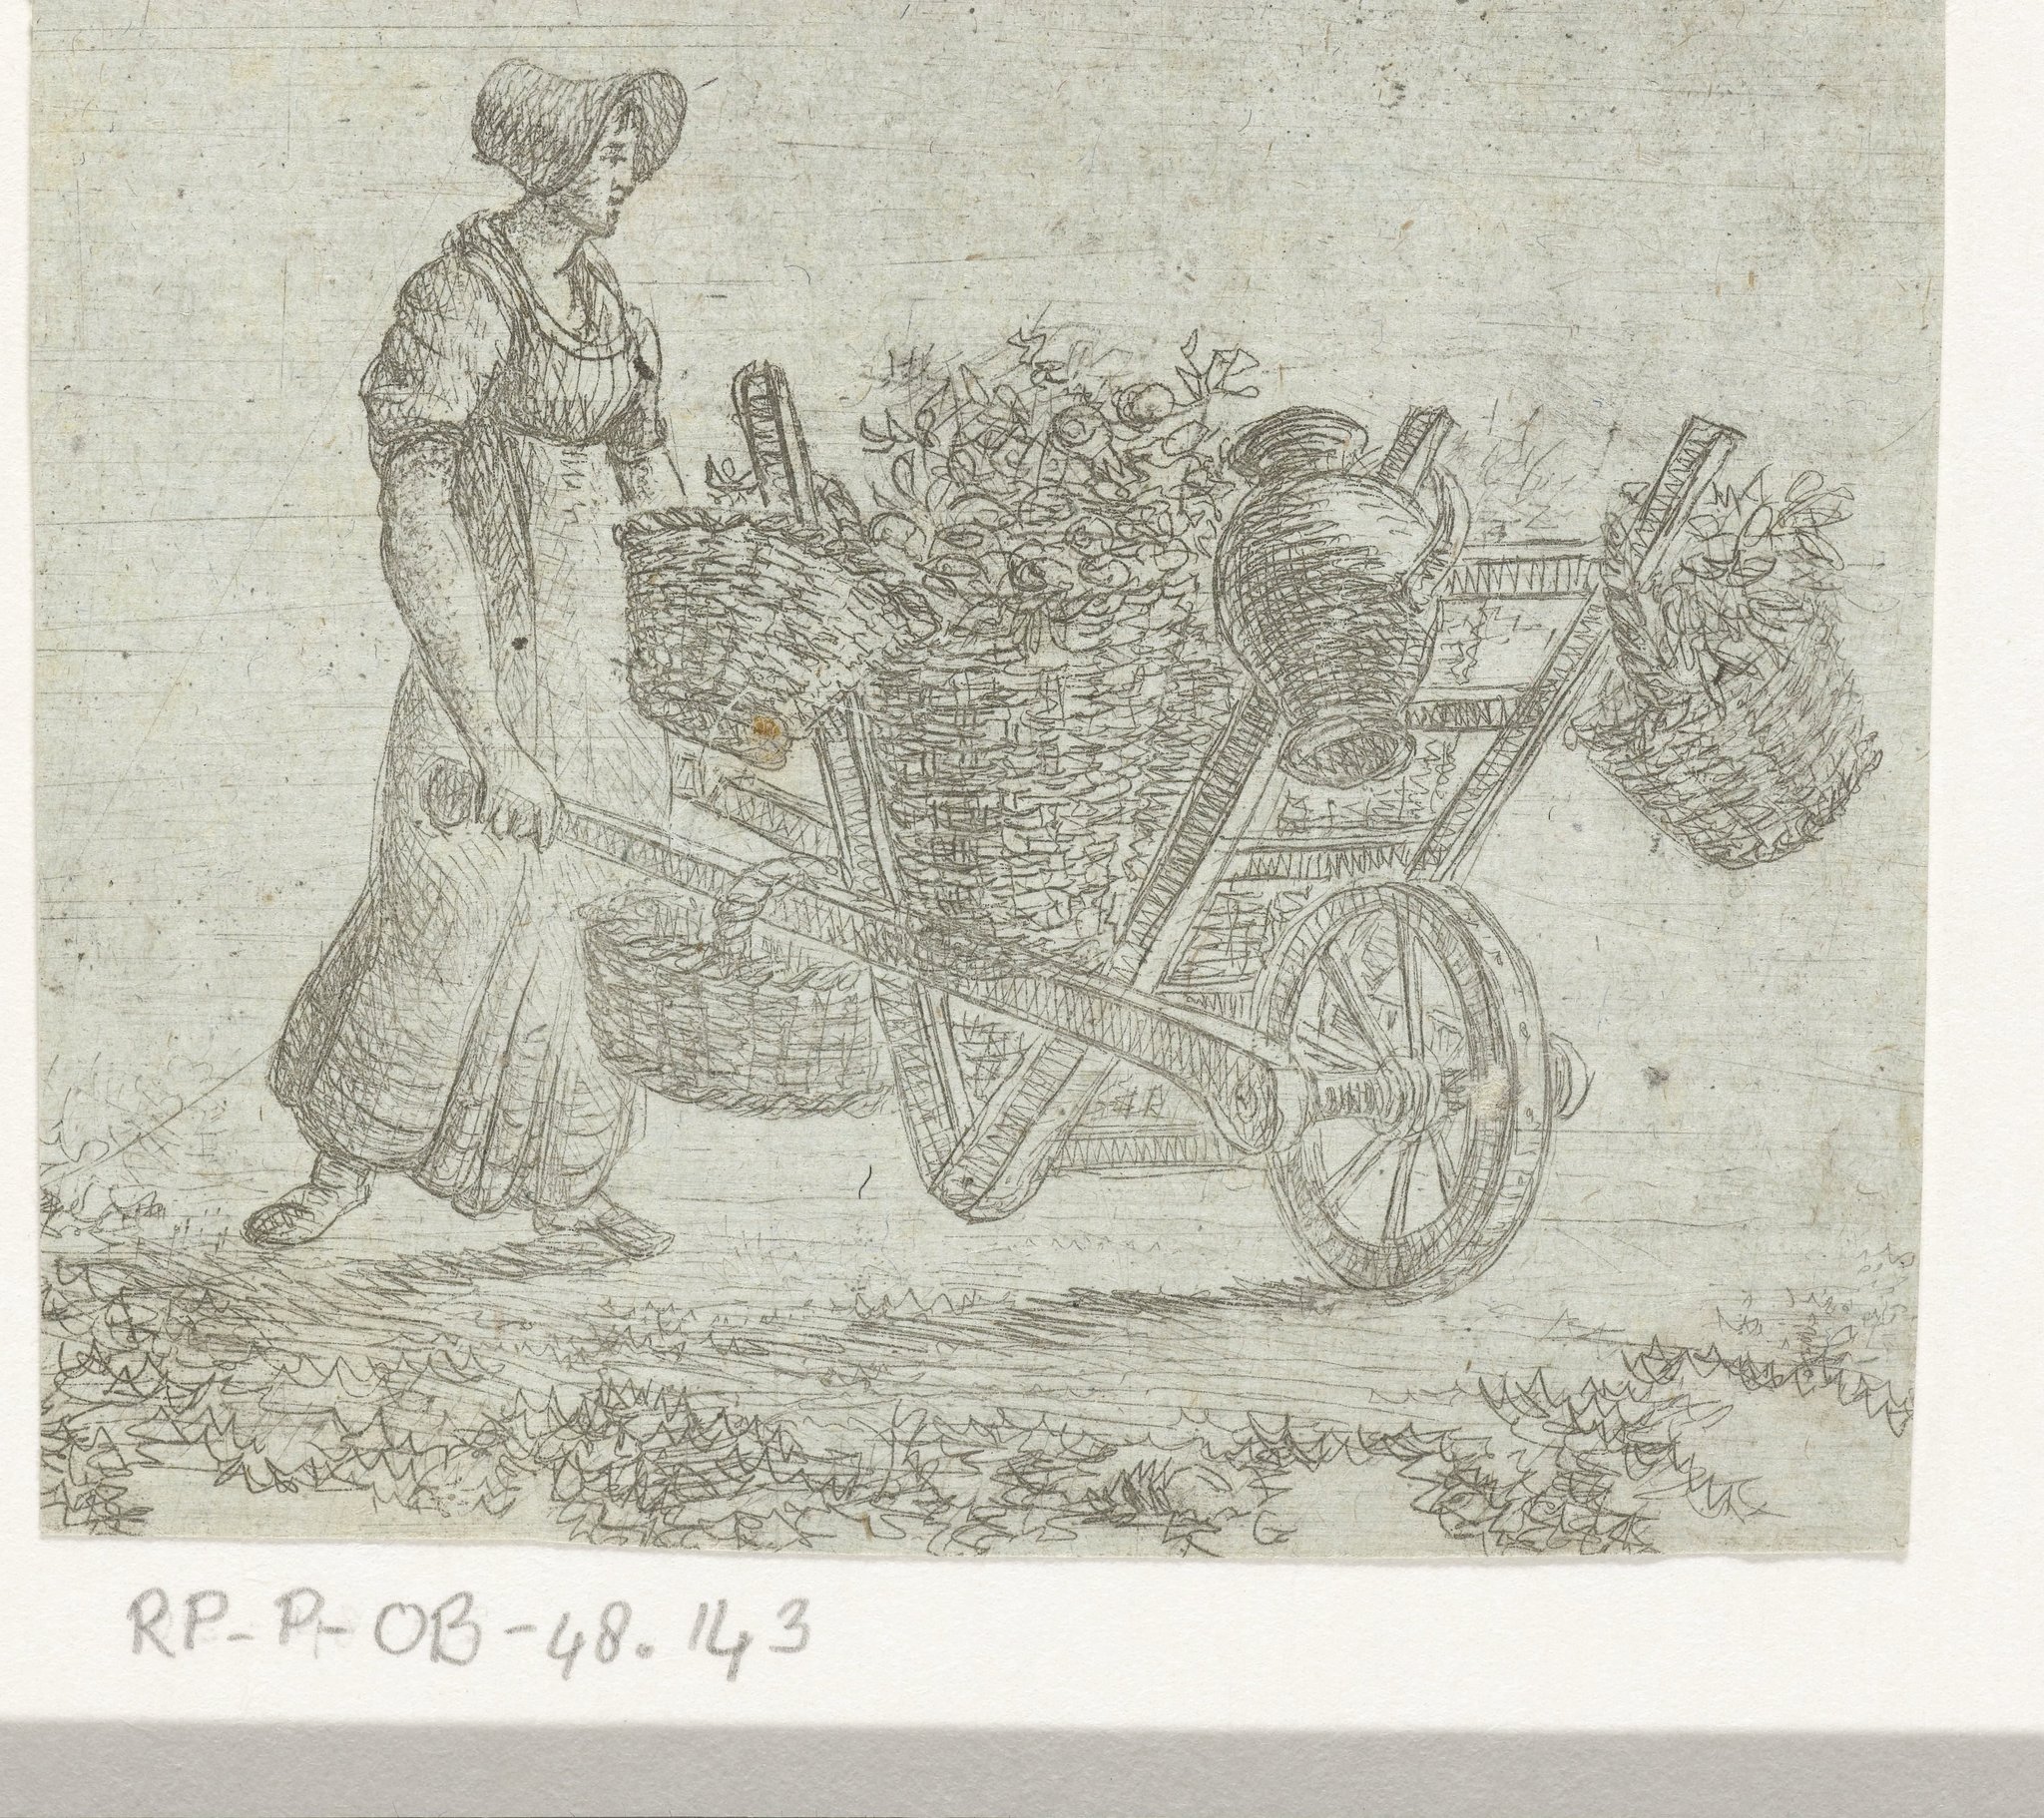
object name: print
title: Vrouw met kruiwagen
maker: otto baron howen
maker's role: draughtsman, print maker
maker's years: 1774-1848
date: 1784-1848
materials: paper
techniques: etching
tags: adult woman (+ front view)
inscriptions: collector's mark: Lugt 2228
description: Een vrouw duwt een kruiwagen met manden naar rechts.